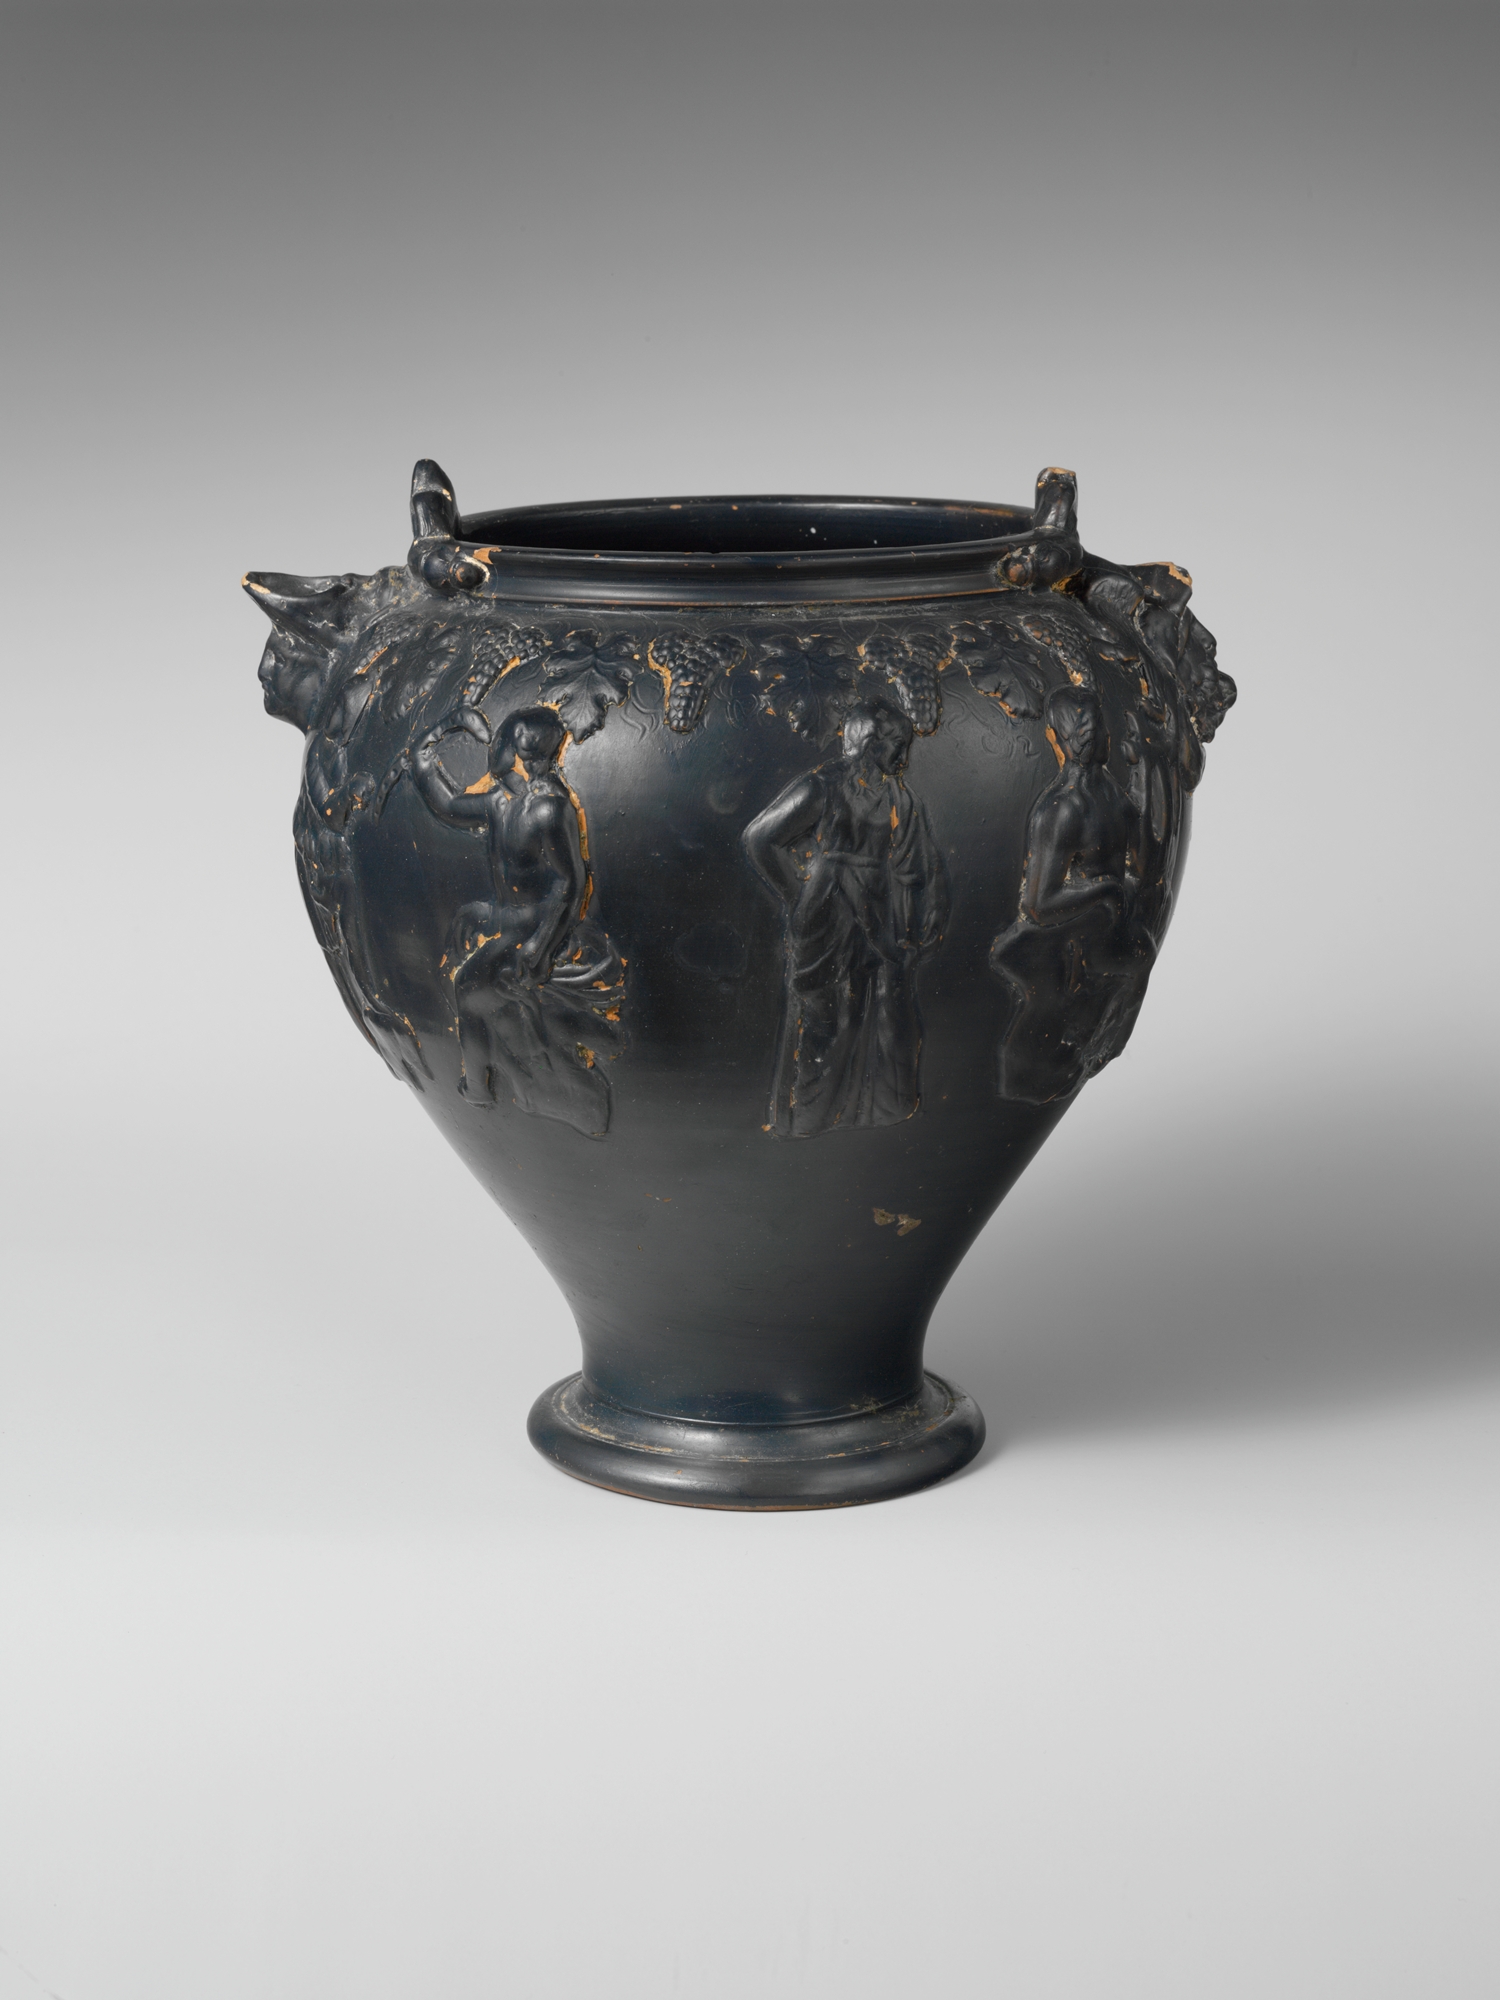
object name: situla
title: Terracotta situla (bucket)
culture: etruscan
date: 300-268 BCE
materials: terracotta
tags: apollo,satyrs